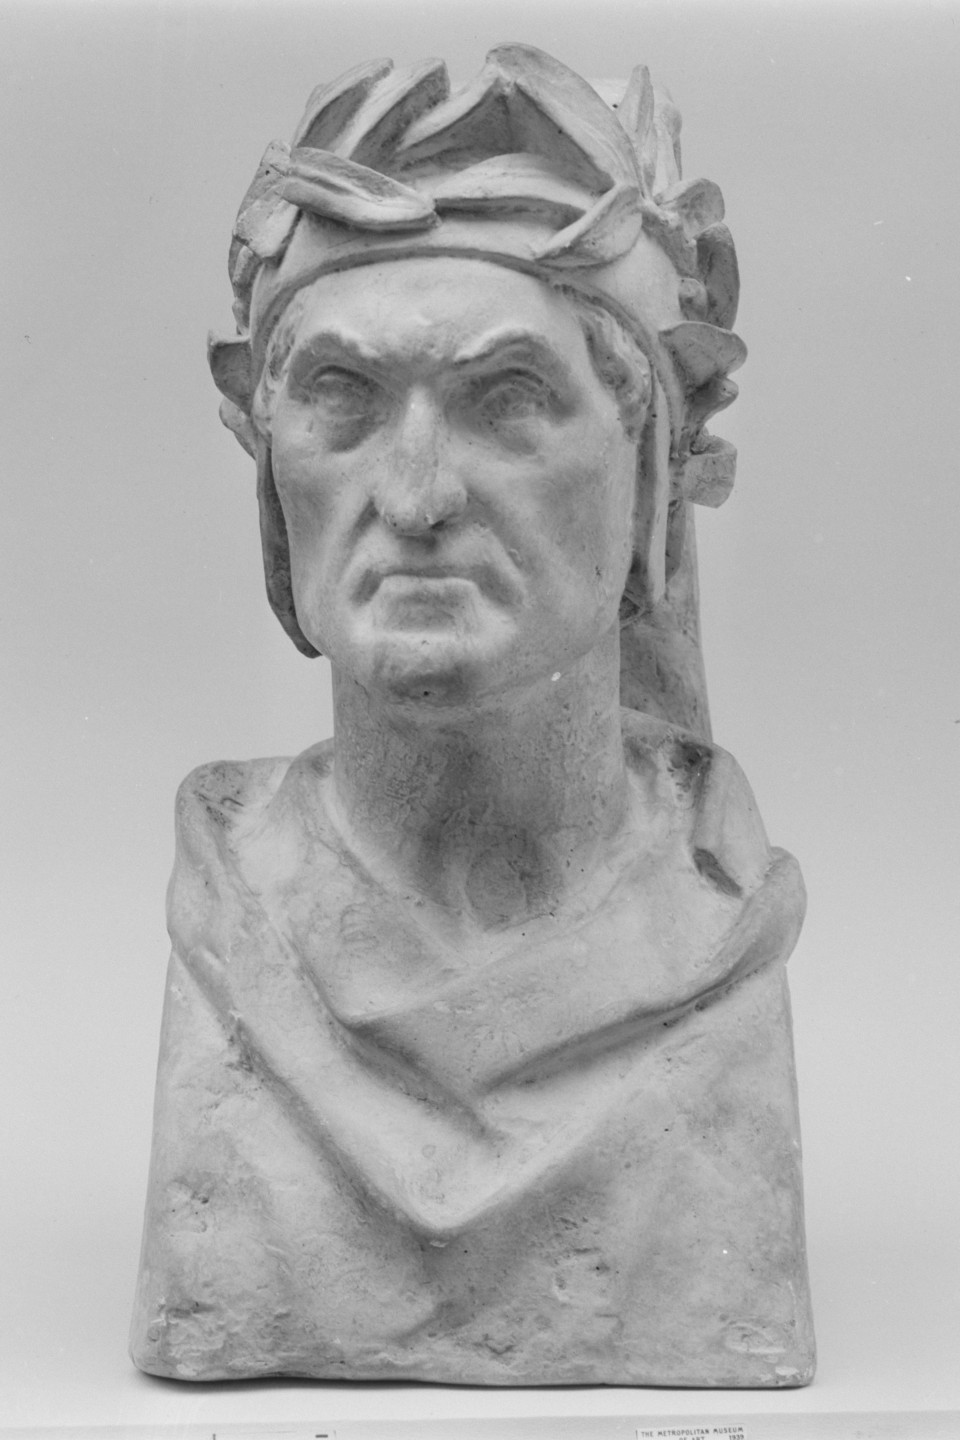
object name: bust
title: Dante Alighieri (1265–1321)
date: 1801-1900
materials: plaster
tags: men,portraits